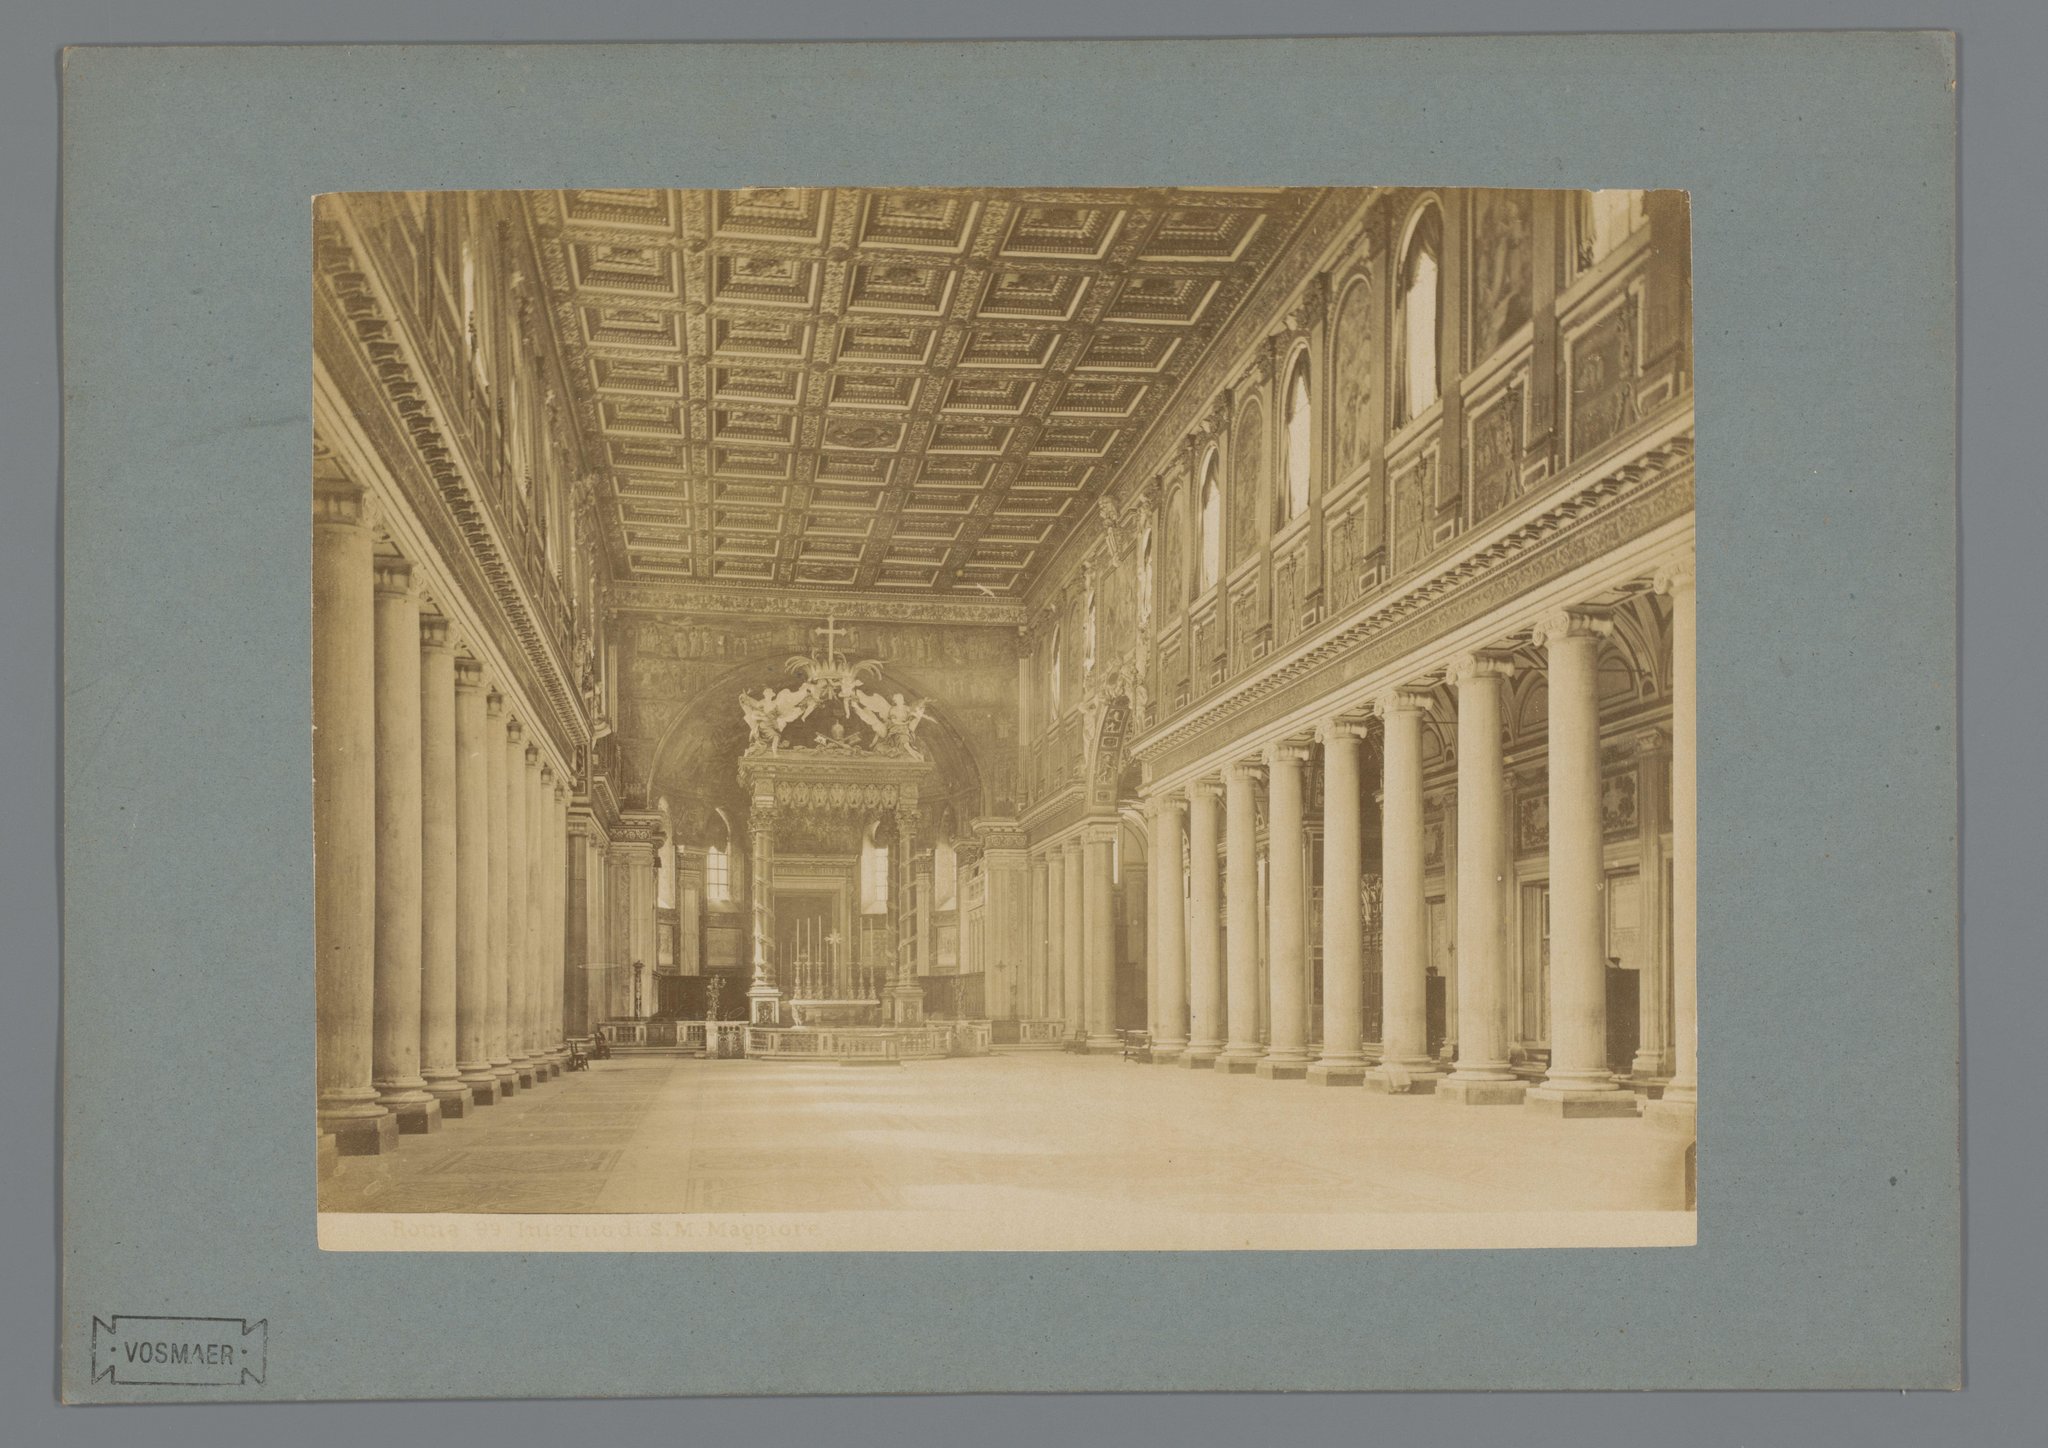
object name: photograph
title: Interno di S. M. Maggiore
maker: Anonymous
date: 1851-1900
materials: cardboard, paper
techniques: albumen print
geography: basiliek van santa maria maggiore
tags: interior of church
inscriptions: number: ‘99.’, collector's mark: ‘VOSMAER’